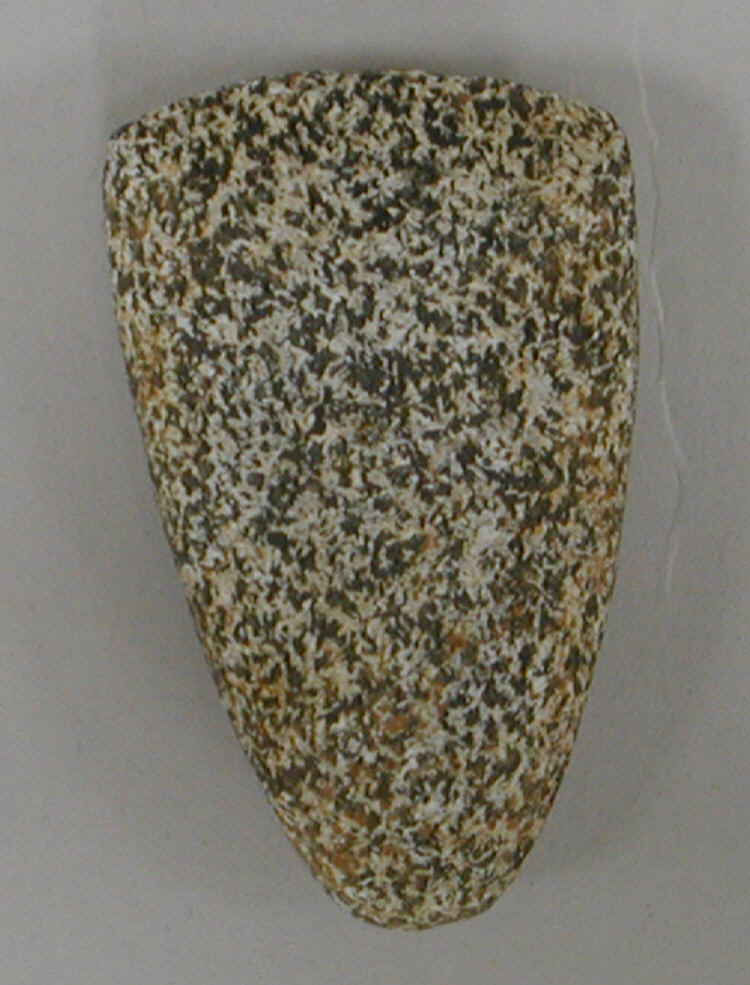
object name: celt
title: Stone Celt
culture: costa rican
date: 1501-1600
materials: stone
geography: costa rica